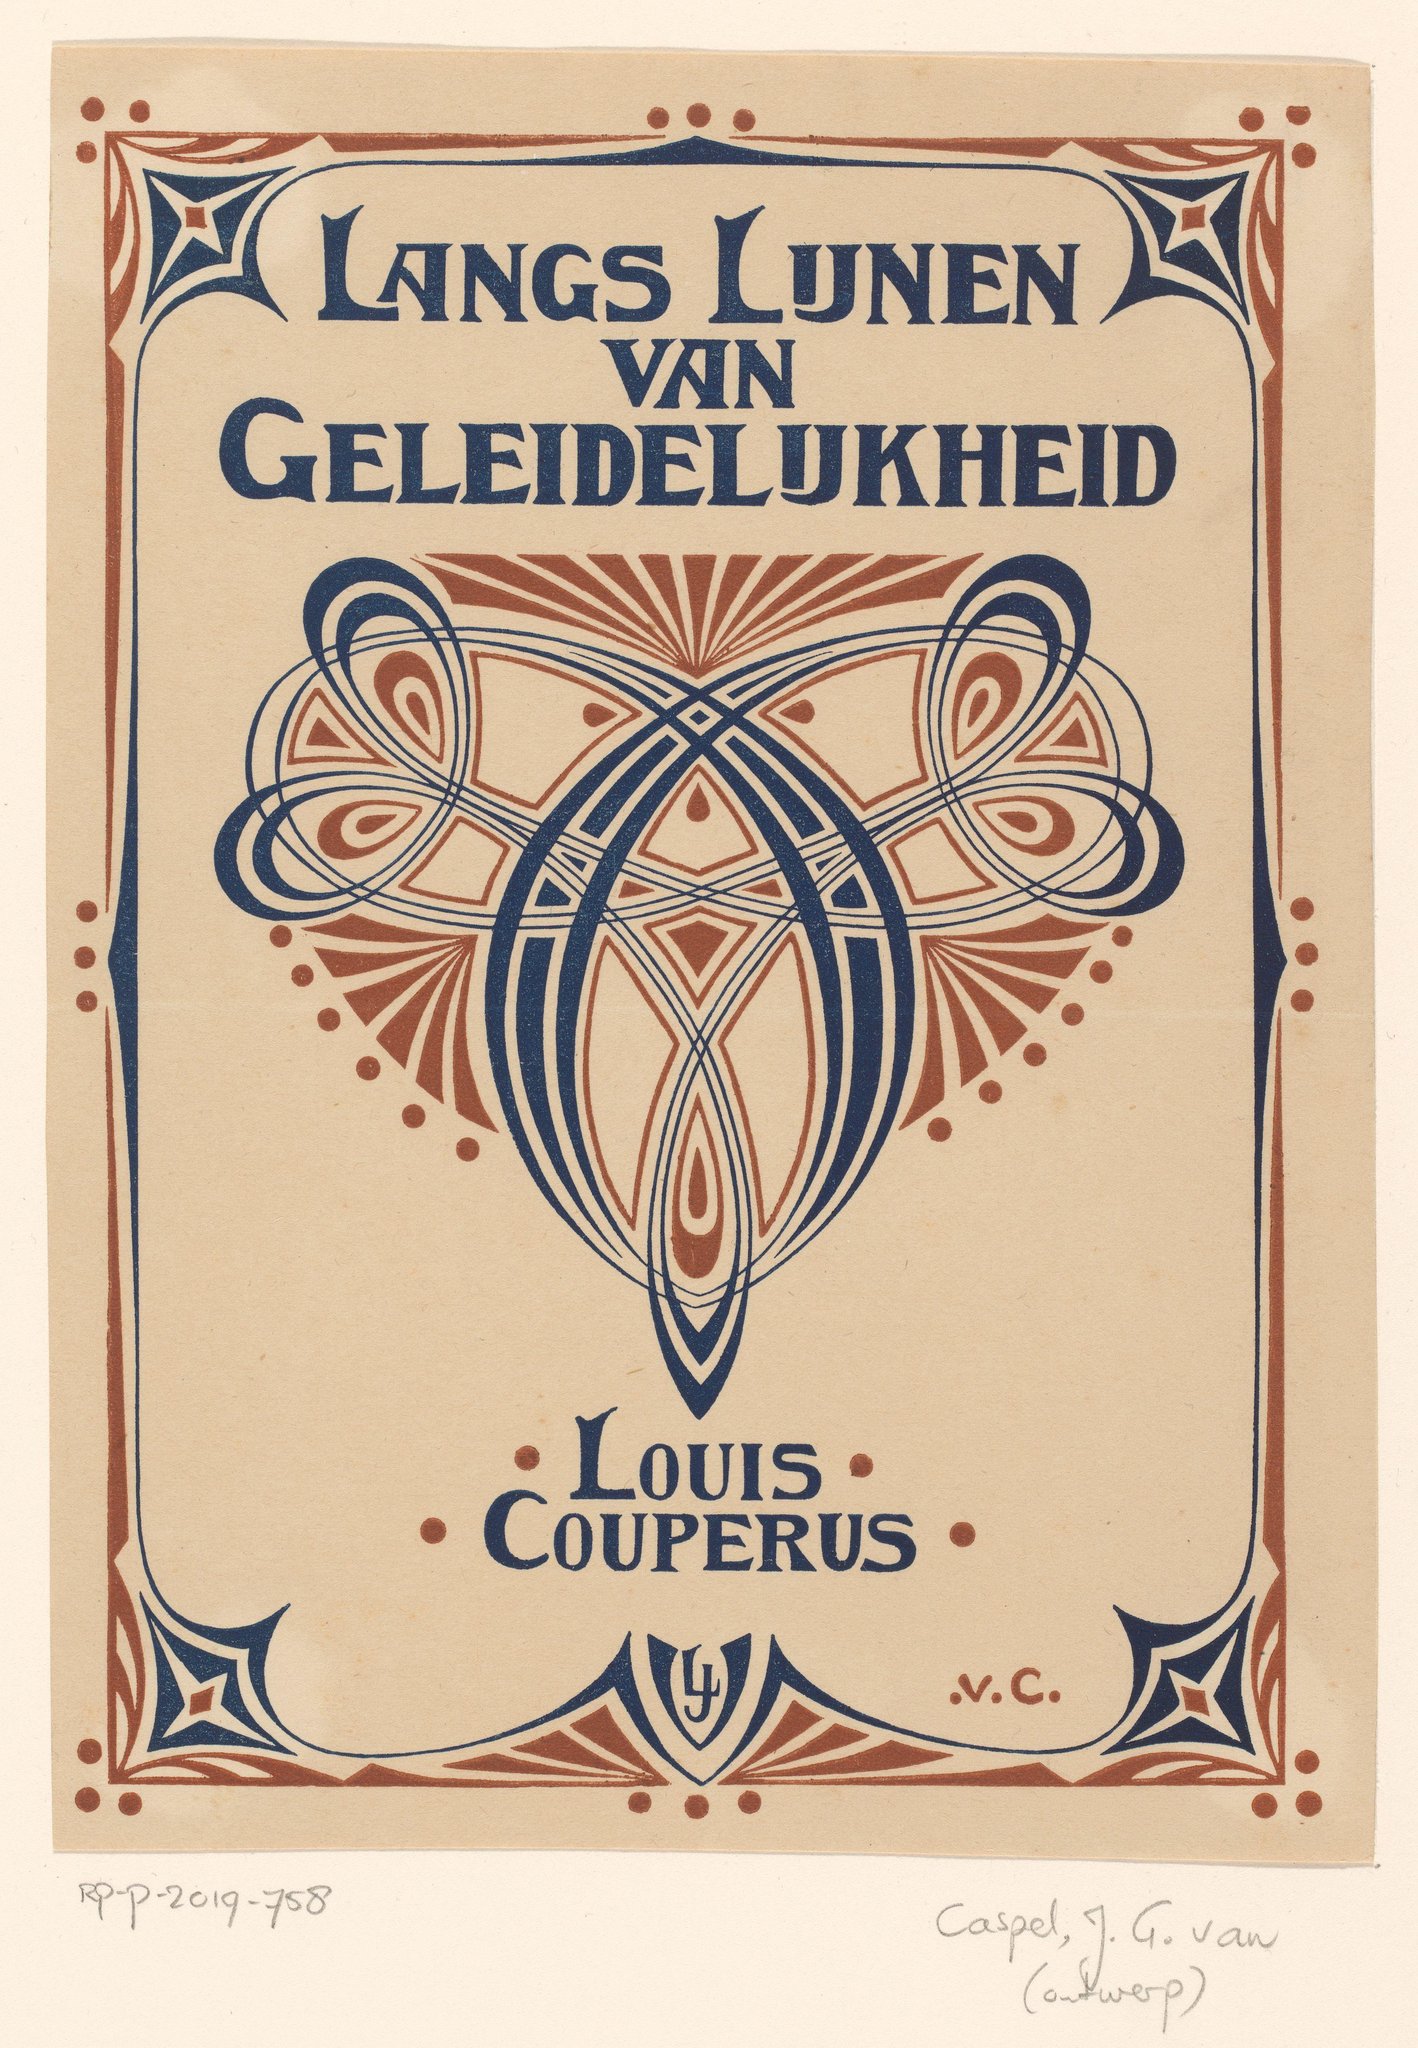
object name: photomechanical print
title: Bandontwerp voor: Louis Couperus, Langs lijnen van geleidelijkheid, 1900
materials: paper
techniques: photochemical processes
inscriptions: collector's mark: Lugt 2228a